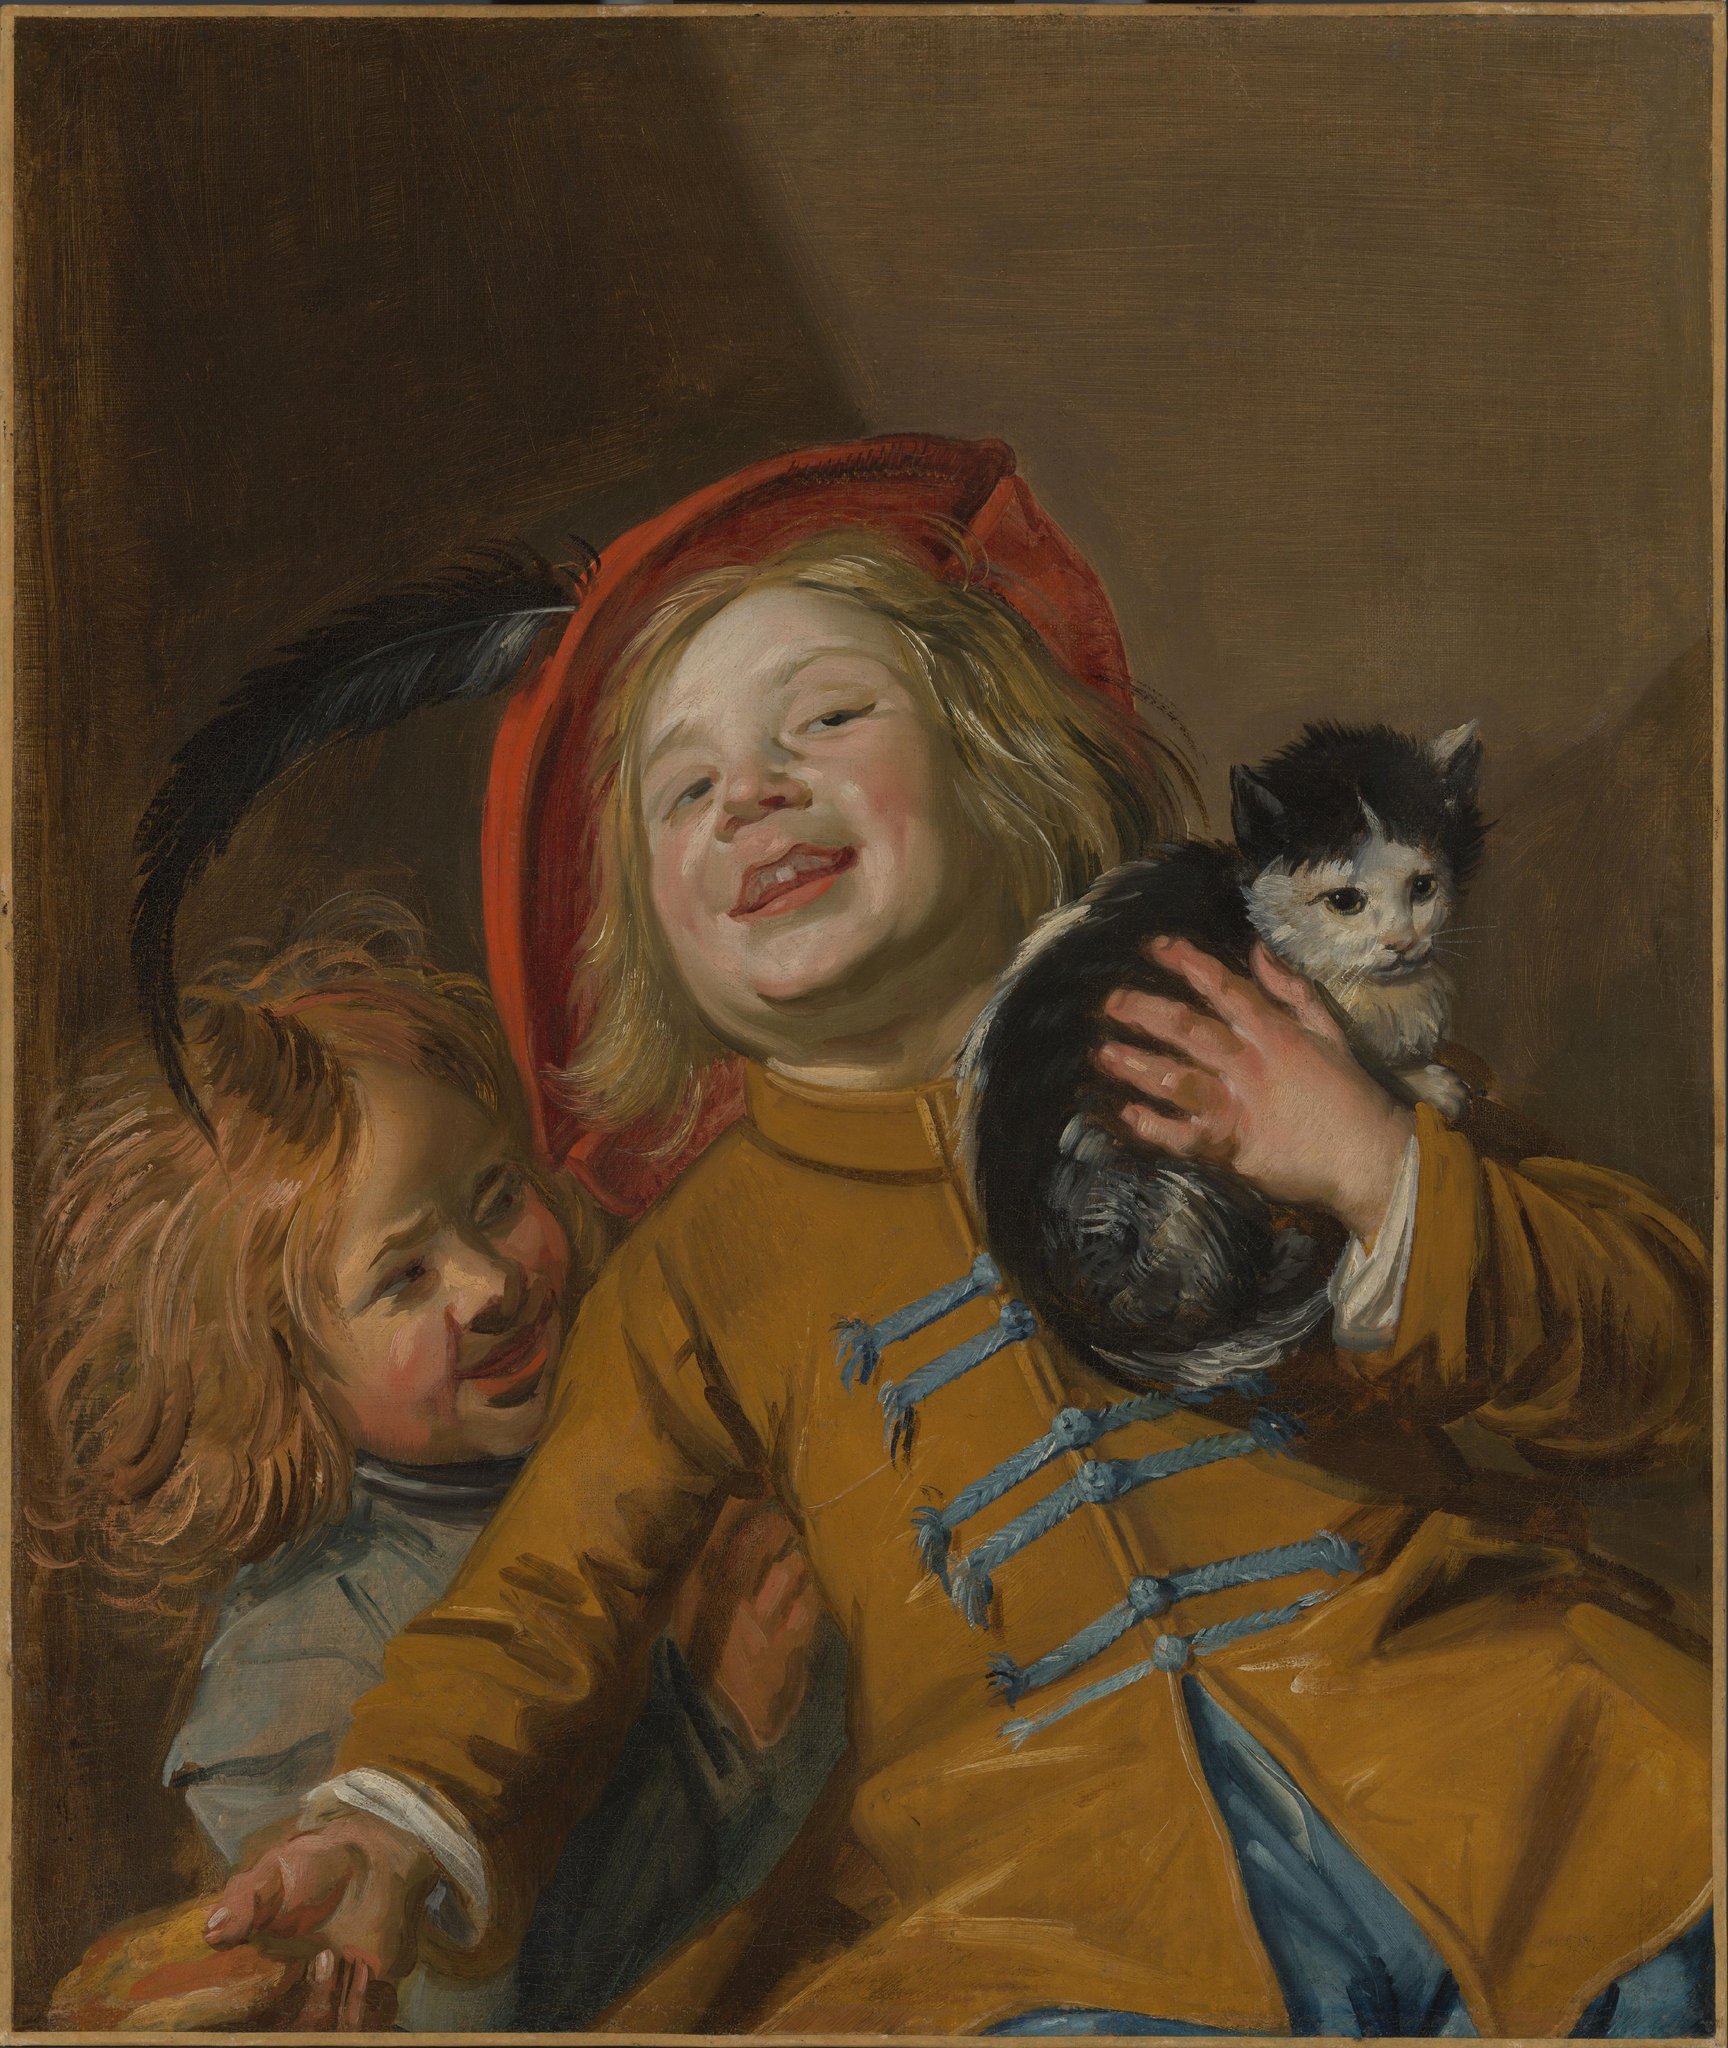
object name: painting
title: Two Children with a Cat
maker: judith leyster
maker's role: painter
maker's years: 1609-1660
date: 1630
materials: canvas, oil, paint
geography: netherlands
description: What fun! The boy in colourful attire abruptly snatches a treat from under the cat’s nose. At the same time, he keeps the animal away from the grabbing hands of the other child. The cat seems afraid of the little boy and might lash out unexpectedly. And then, it would become a mix of laughter and tears. Judith Leyster’s loose painting style contributes to the vivacity.